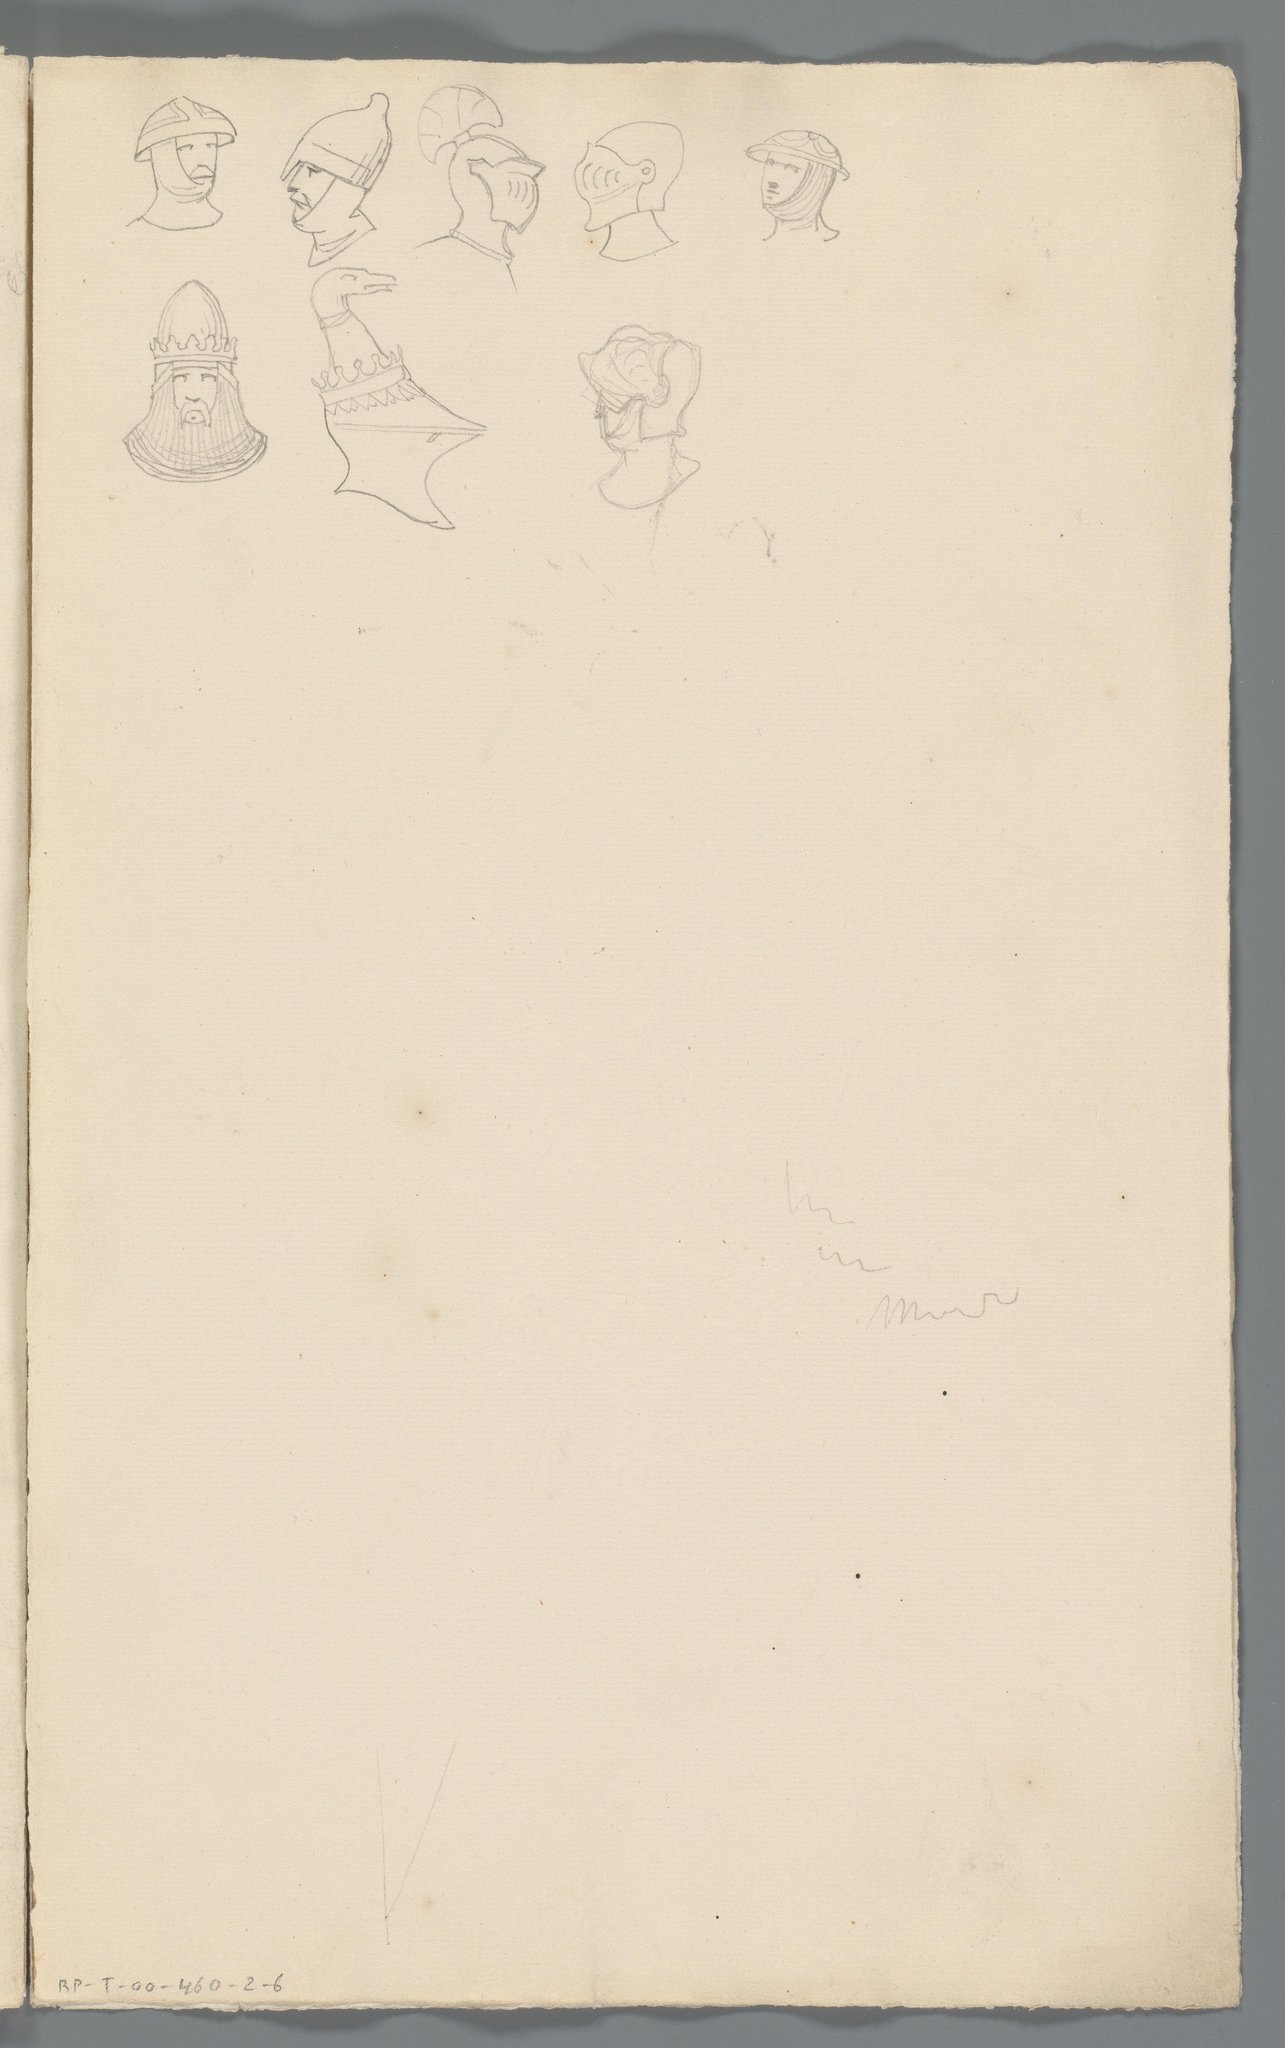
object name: drawing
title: Middeleeuwse helmen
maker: jacobus everhardus josephus van den berg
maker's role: draughtsman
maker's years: 1802-1861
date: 1812-1861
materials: paper, pencil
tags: helmet, medieval history, middle ages (historical epoch)